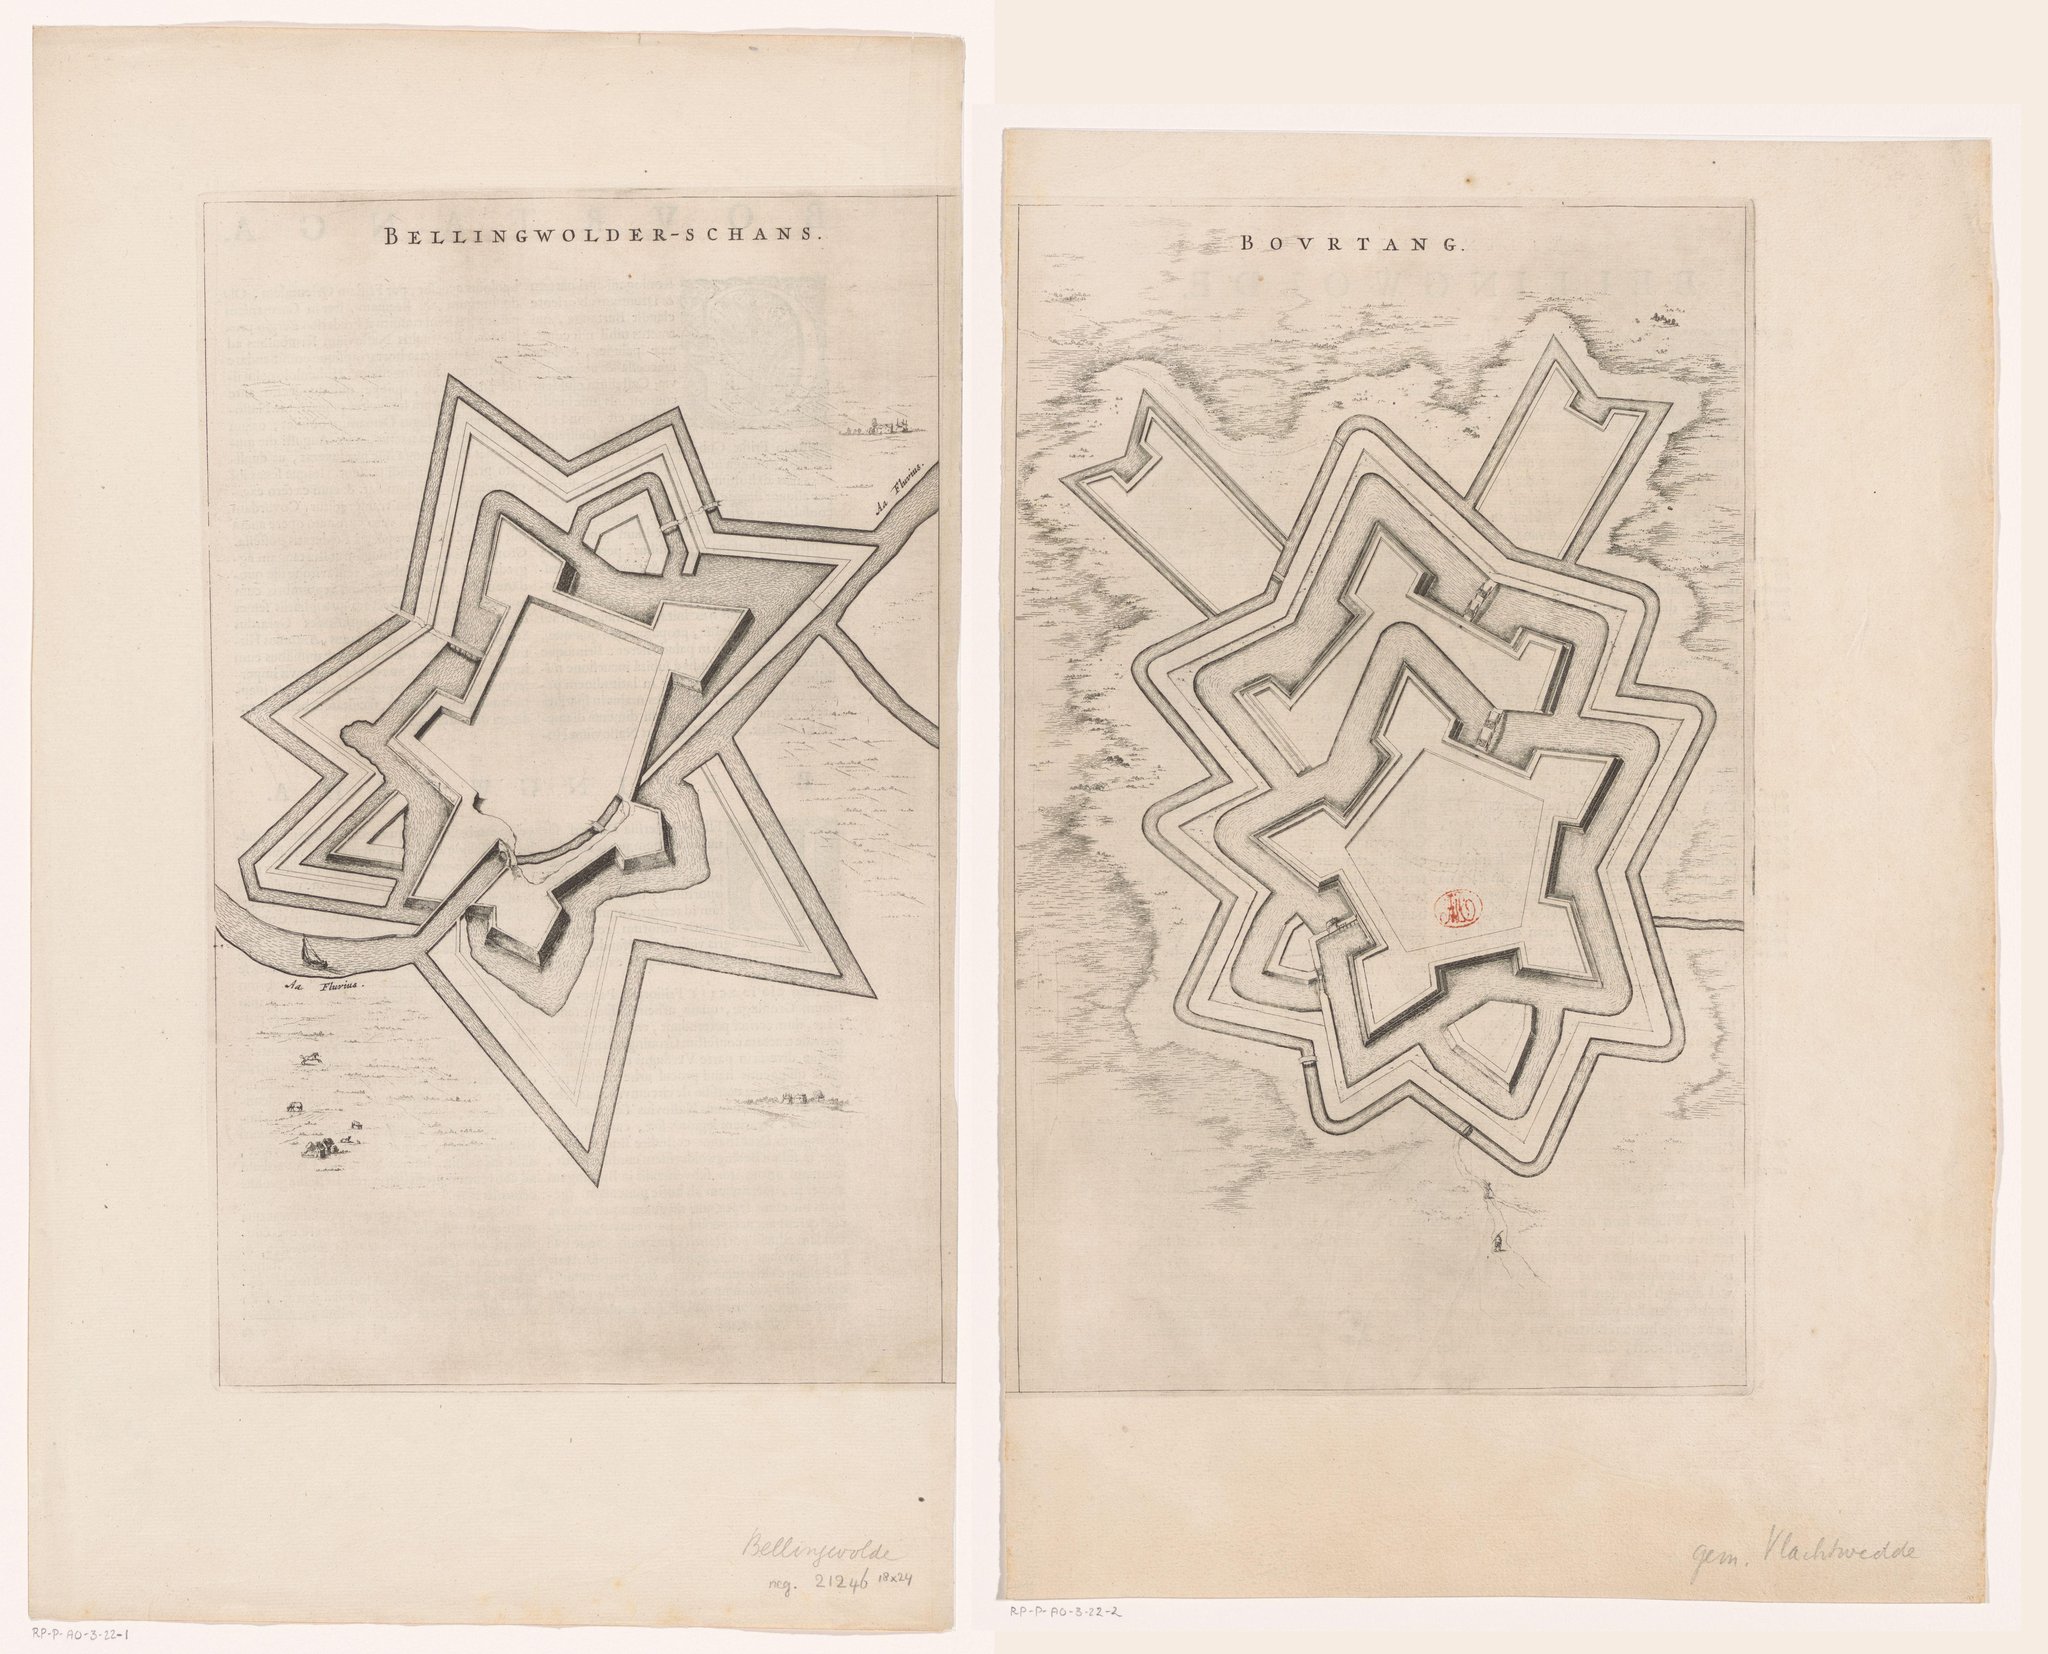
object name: area plan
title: Bourtang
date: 1652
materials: paper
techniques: engraving, etching, letterpress printing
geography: amsterdam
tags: fortress, maps of cities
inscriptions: collector's mark: Lugt 195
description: Dit object is omwille van een betere presentatie virtueel samengevoegd maar bestaat fysiek uit losse onderdelen. Prent gebruikt in: Blaeu, Johannes Willemszoon. Toonneel der steden van de Vereenighde Nederlanden. 2 delen. Amsterdam: Johannes Willemszoon Blaeu, 1652, dl. 1.